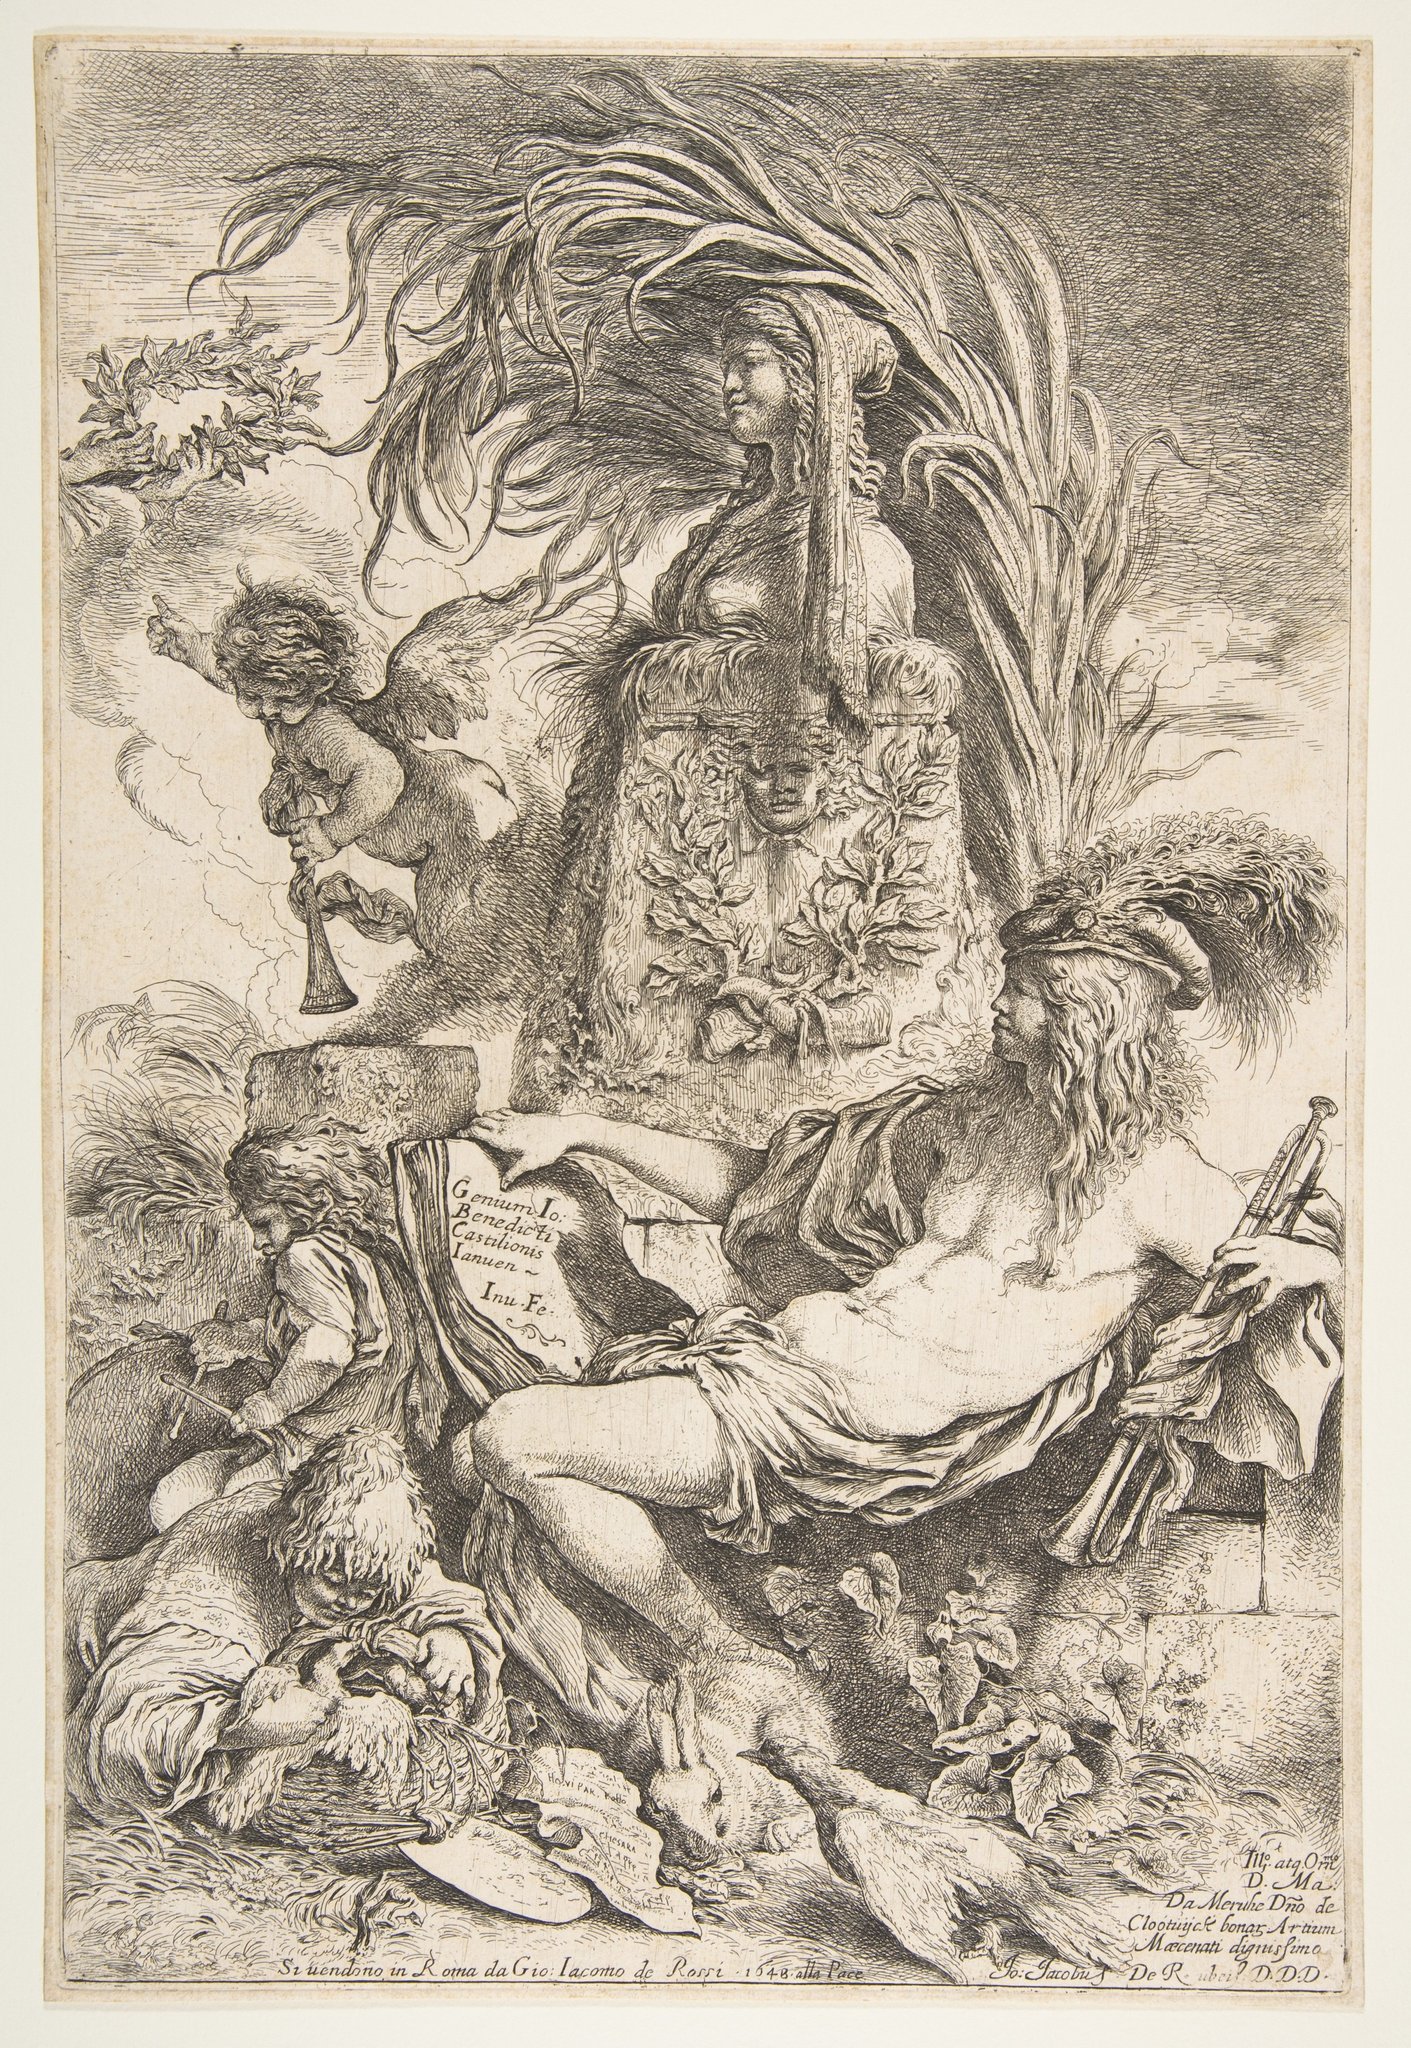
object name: print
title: The Genius of Castiglione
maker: giovanni benedetto castiglione (il grechetto)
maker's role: artist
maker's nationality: italian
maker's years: 1609-1664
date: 1645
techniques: etching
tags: musical instruments,faces,men,women